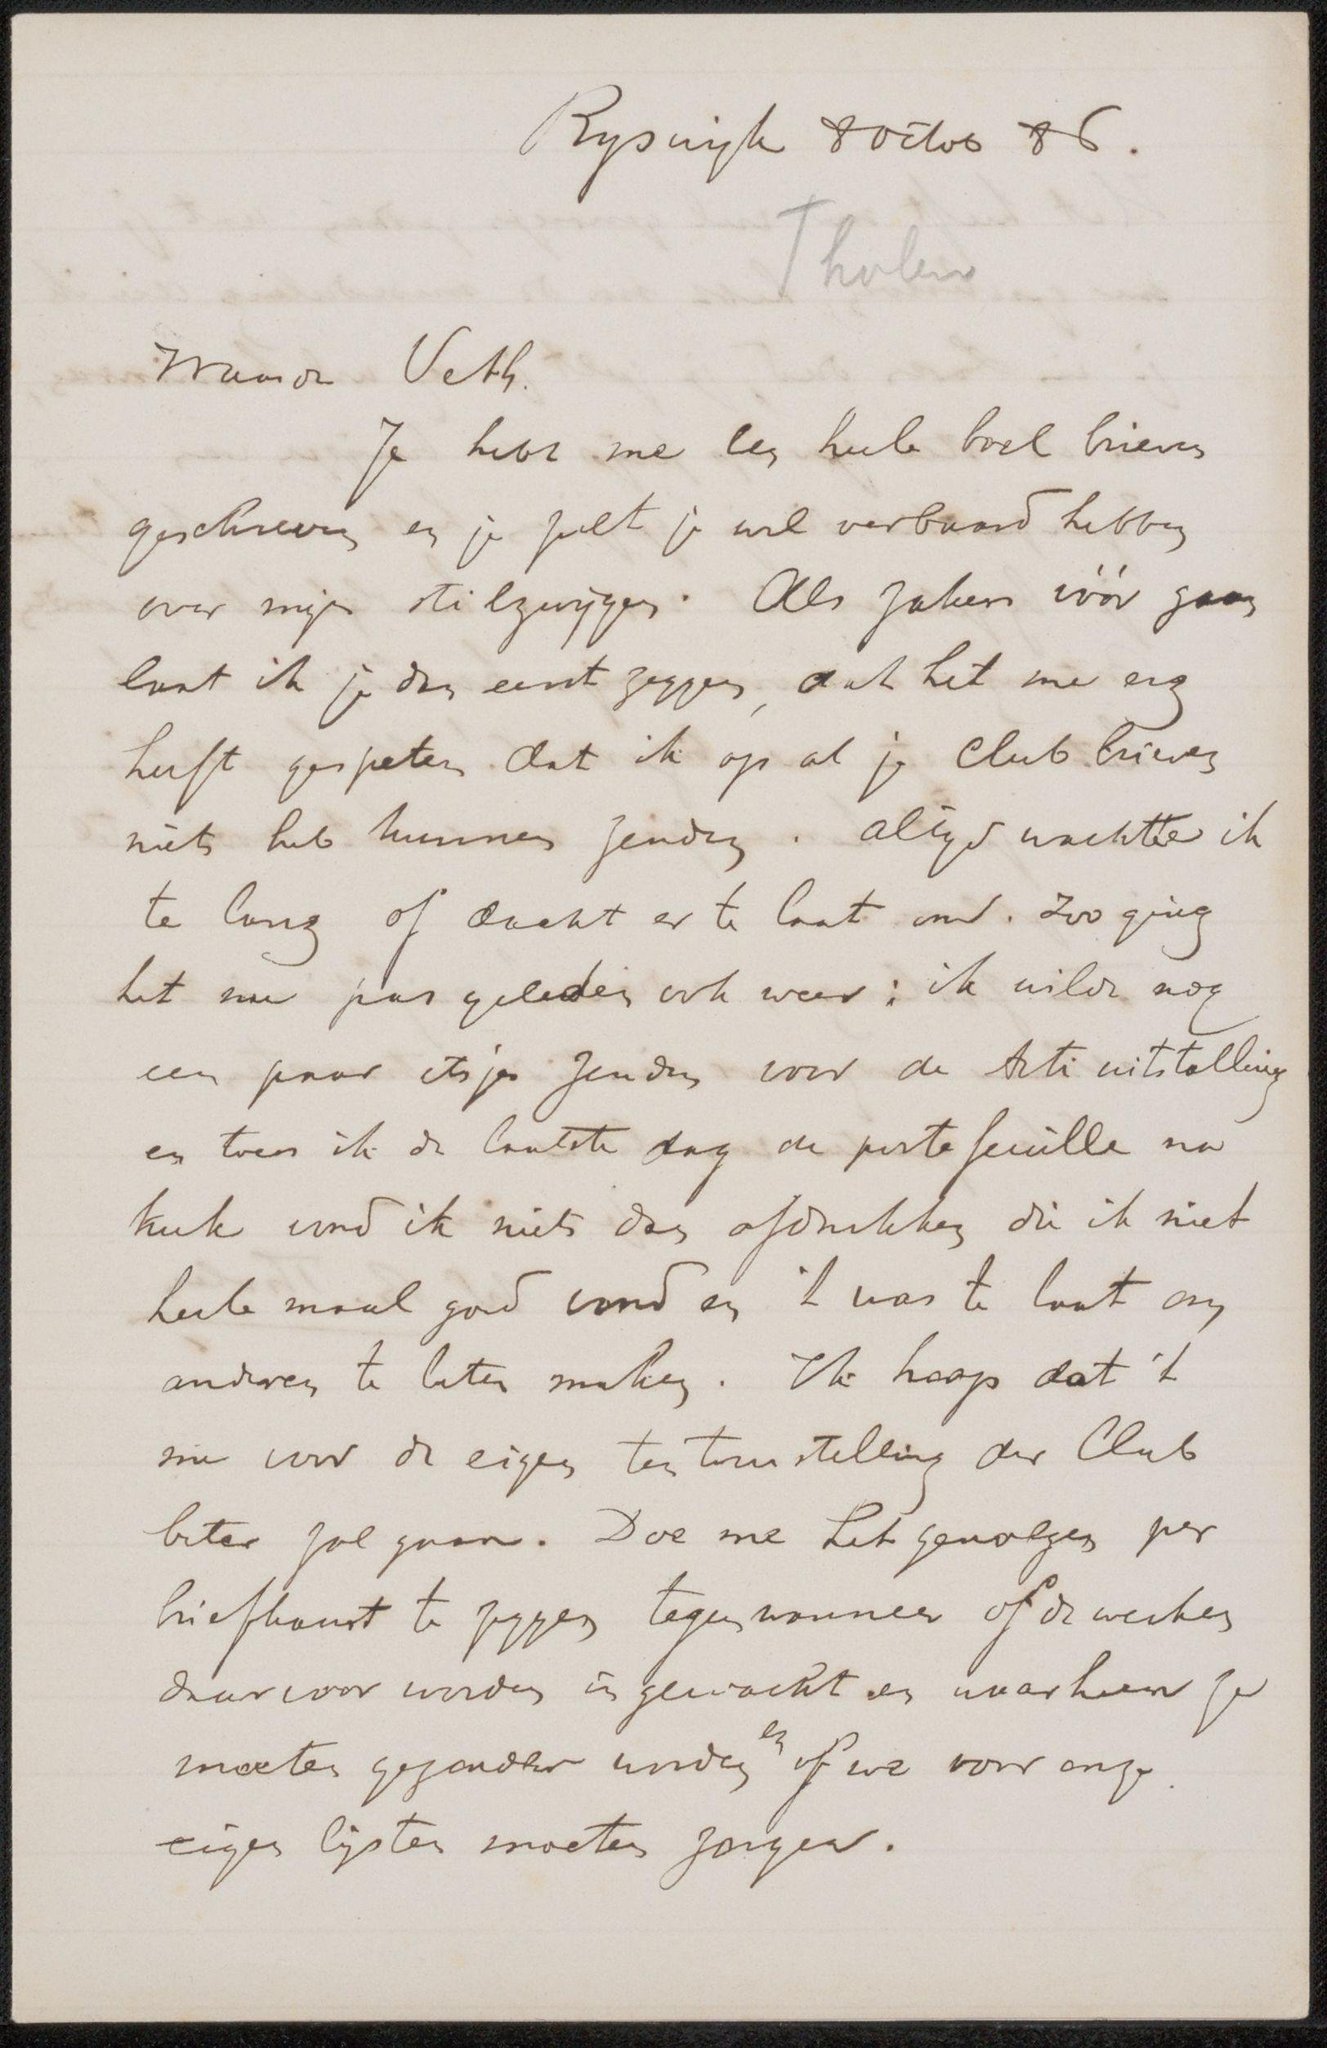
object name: letter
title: Brief aan Jan Veth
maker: willem bastiaan tholen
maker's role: draughtsman, painter, print maker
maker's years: 1860-1931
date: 1886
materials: ink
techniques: pen, writing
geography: rijswijk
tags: dordrecht, designer, jan veth, the graphic arts, exhibition ~ art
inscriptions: collector's mark: ‘RPK’